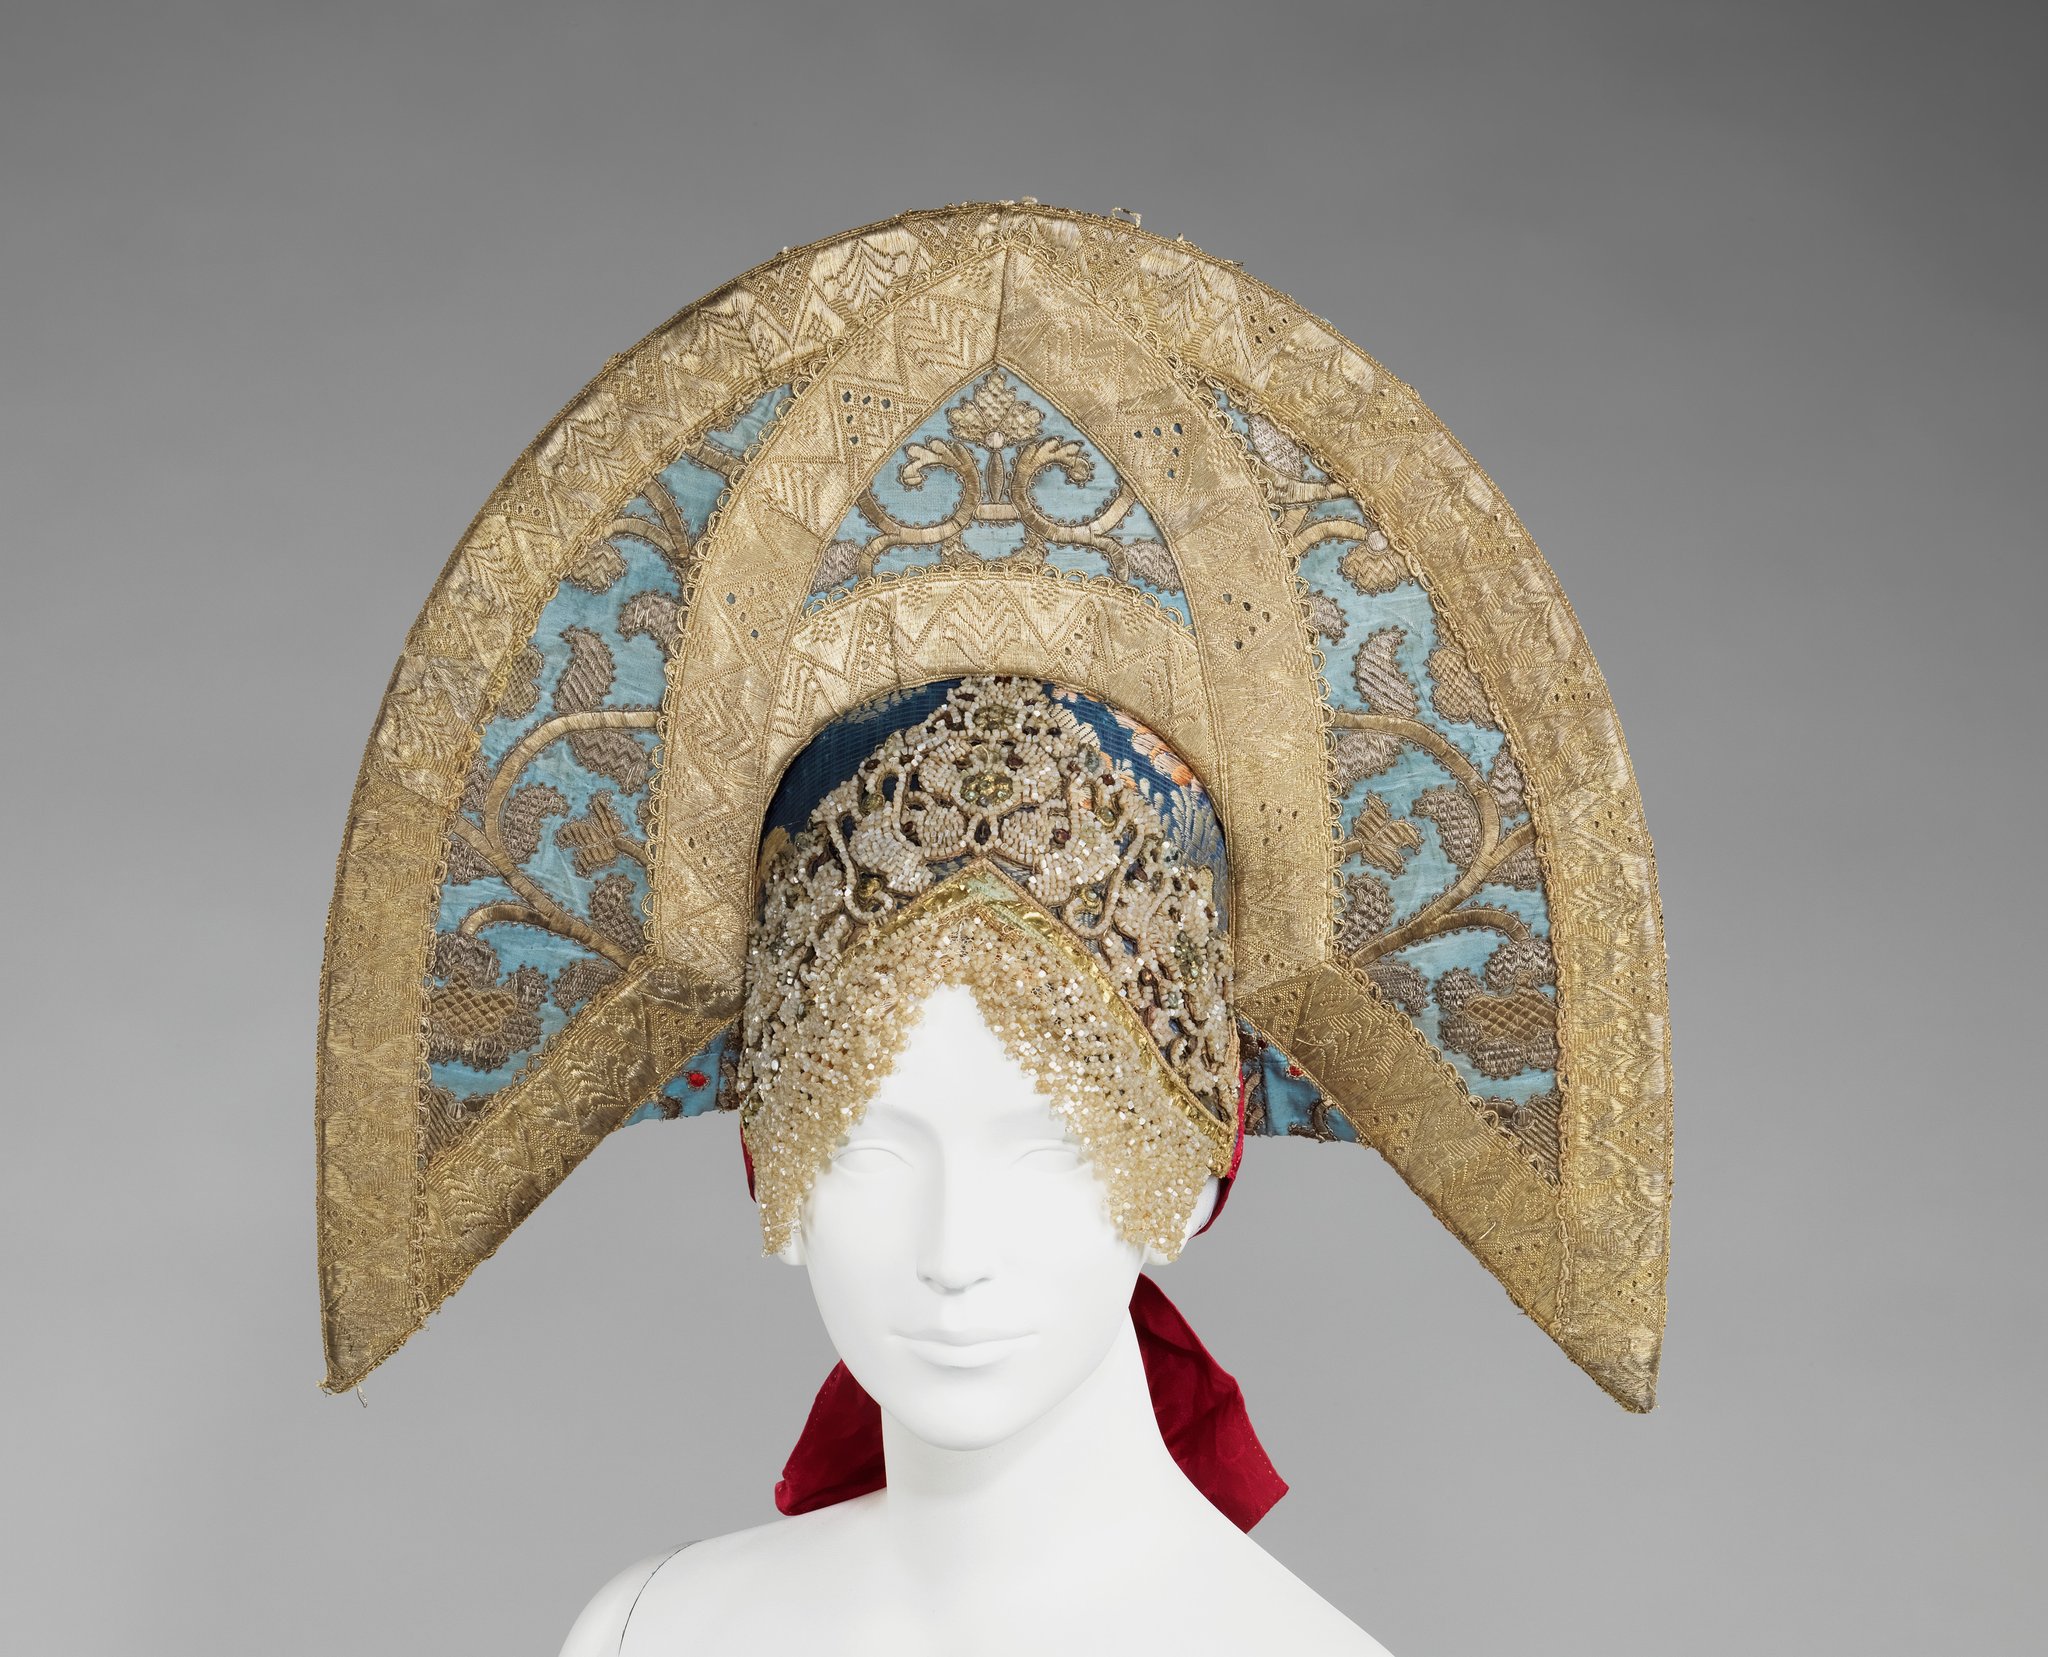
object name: headdress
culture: russian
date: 1801-1833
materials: cotton, glass, metal, mother of pearl, silk, stone